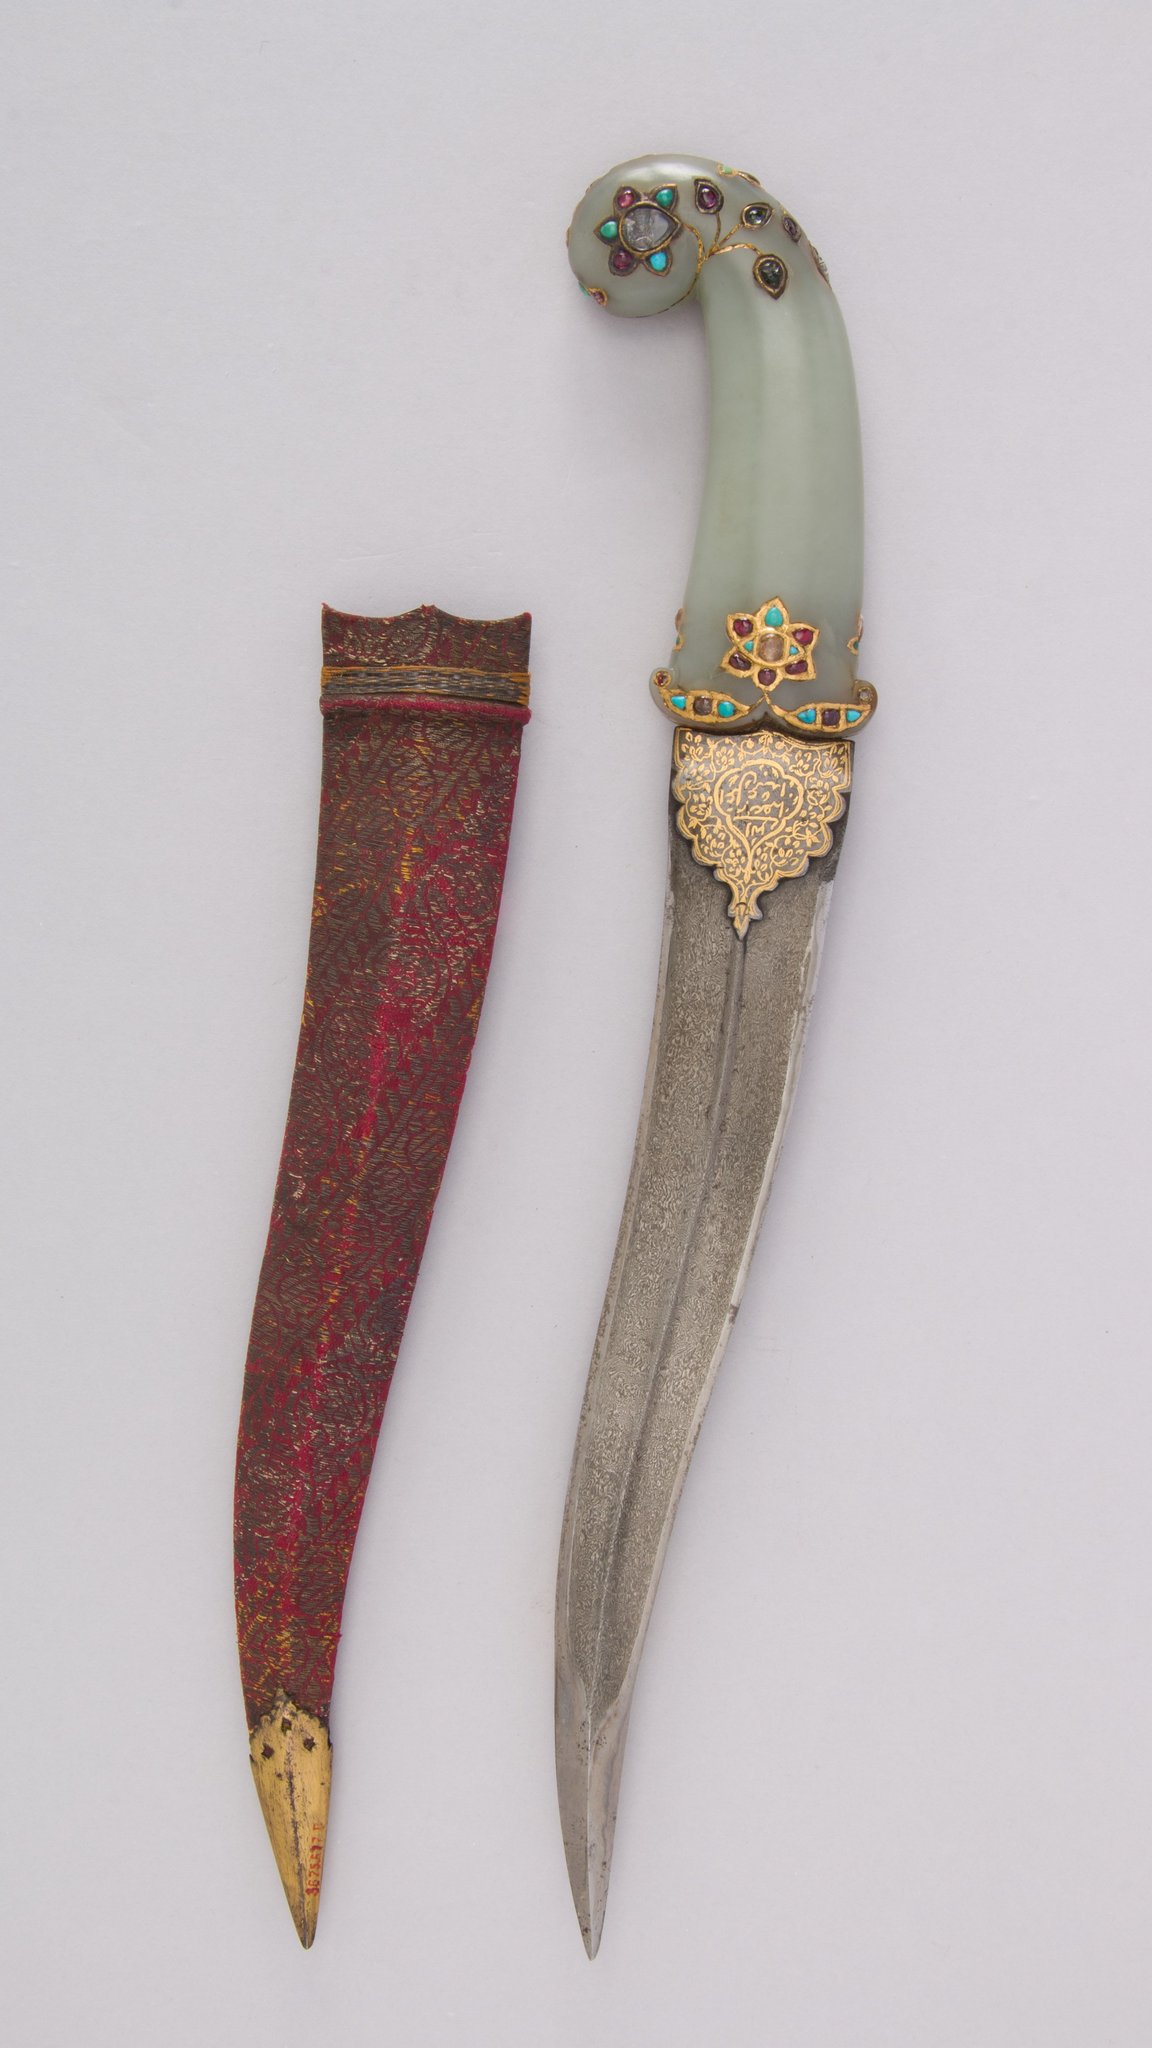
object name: dagger khanjar with sheath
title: Dagger (Khanjar) with Sheath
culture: indian, deccan or mughal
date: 1701-1900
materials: copper, crystal, gemstone, gold, jade, silk, silver, steel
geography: india